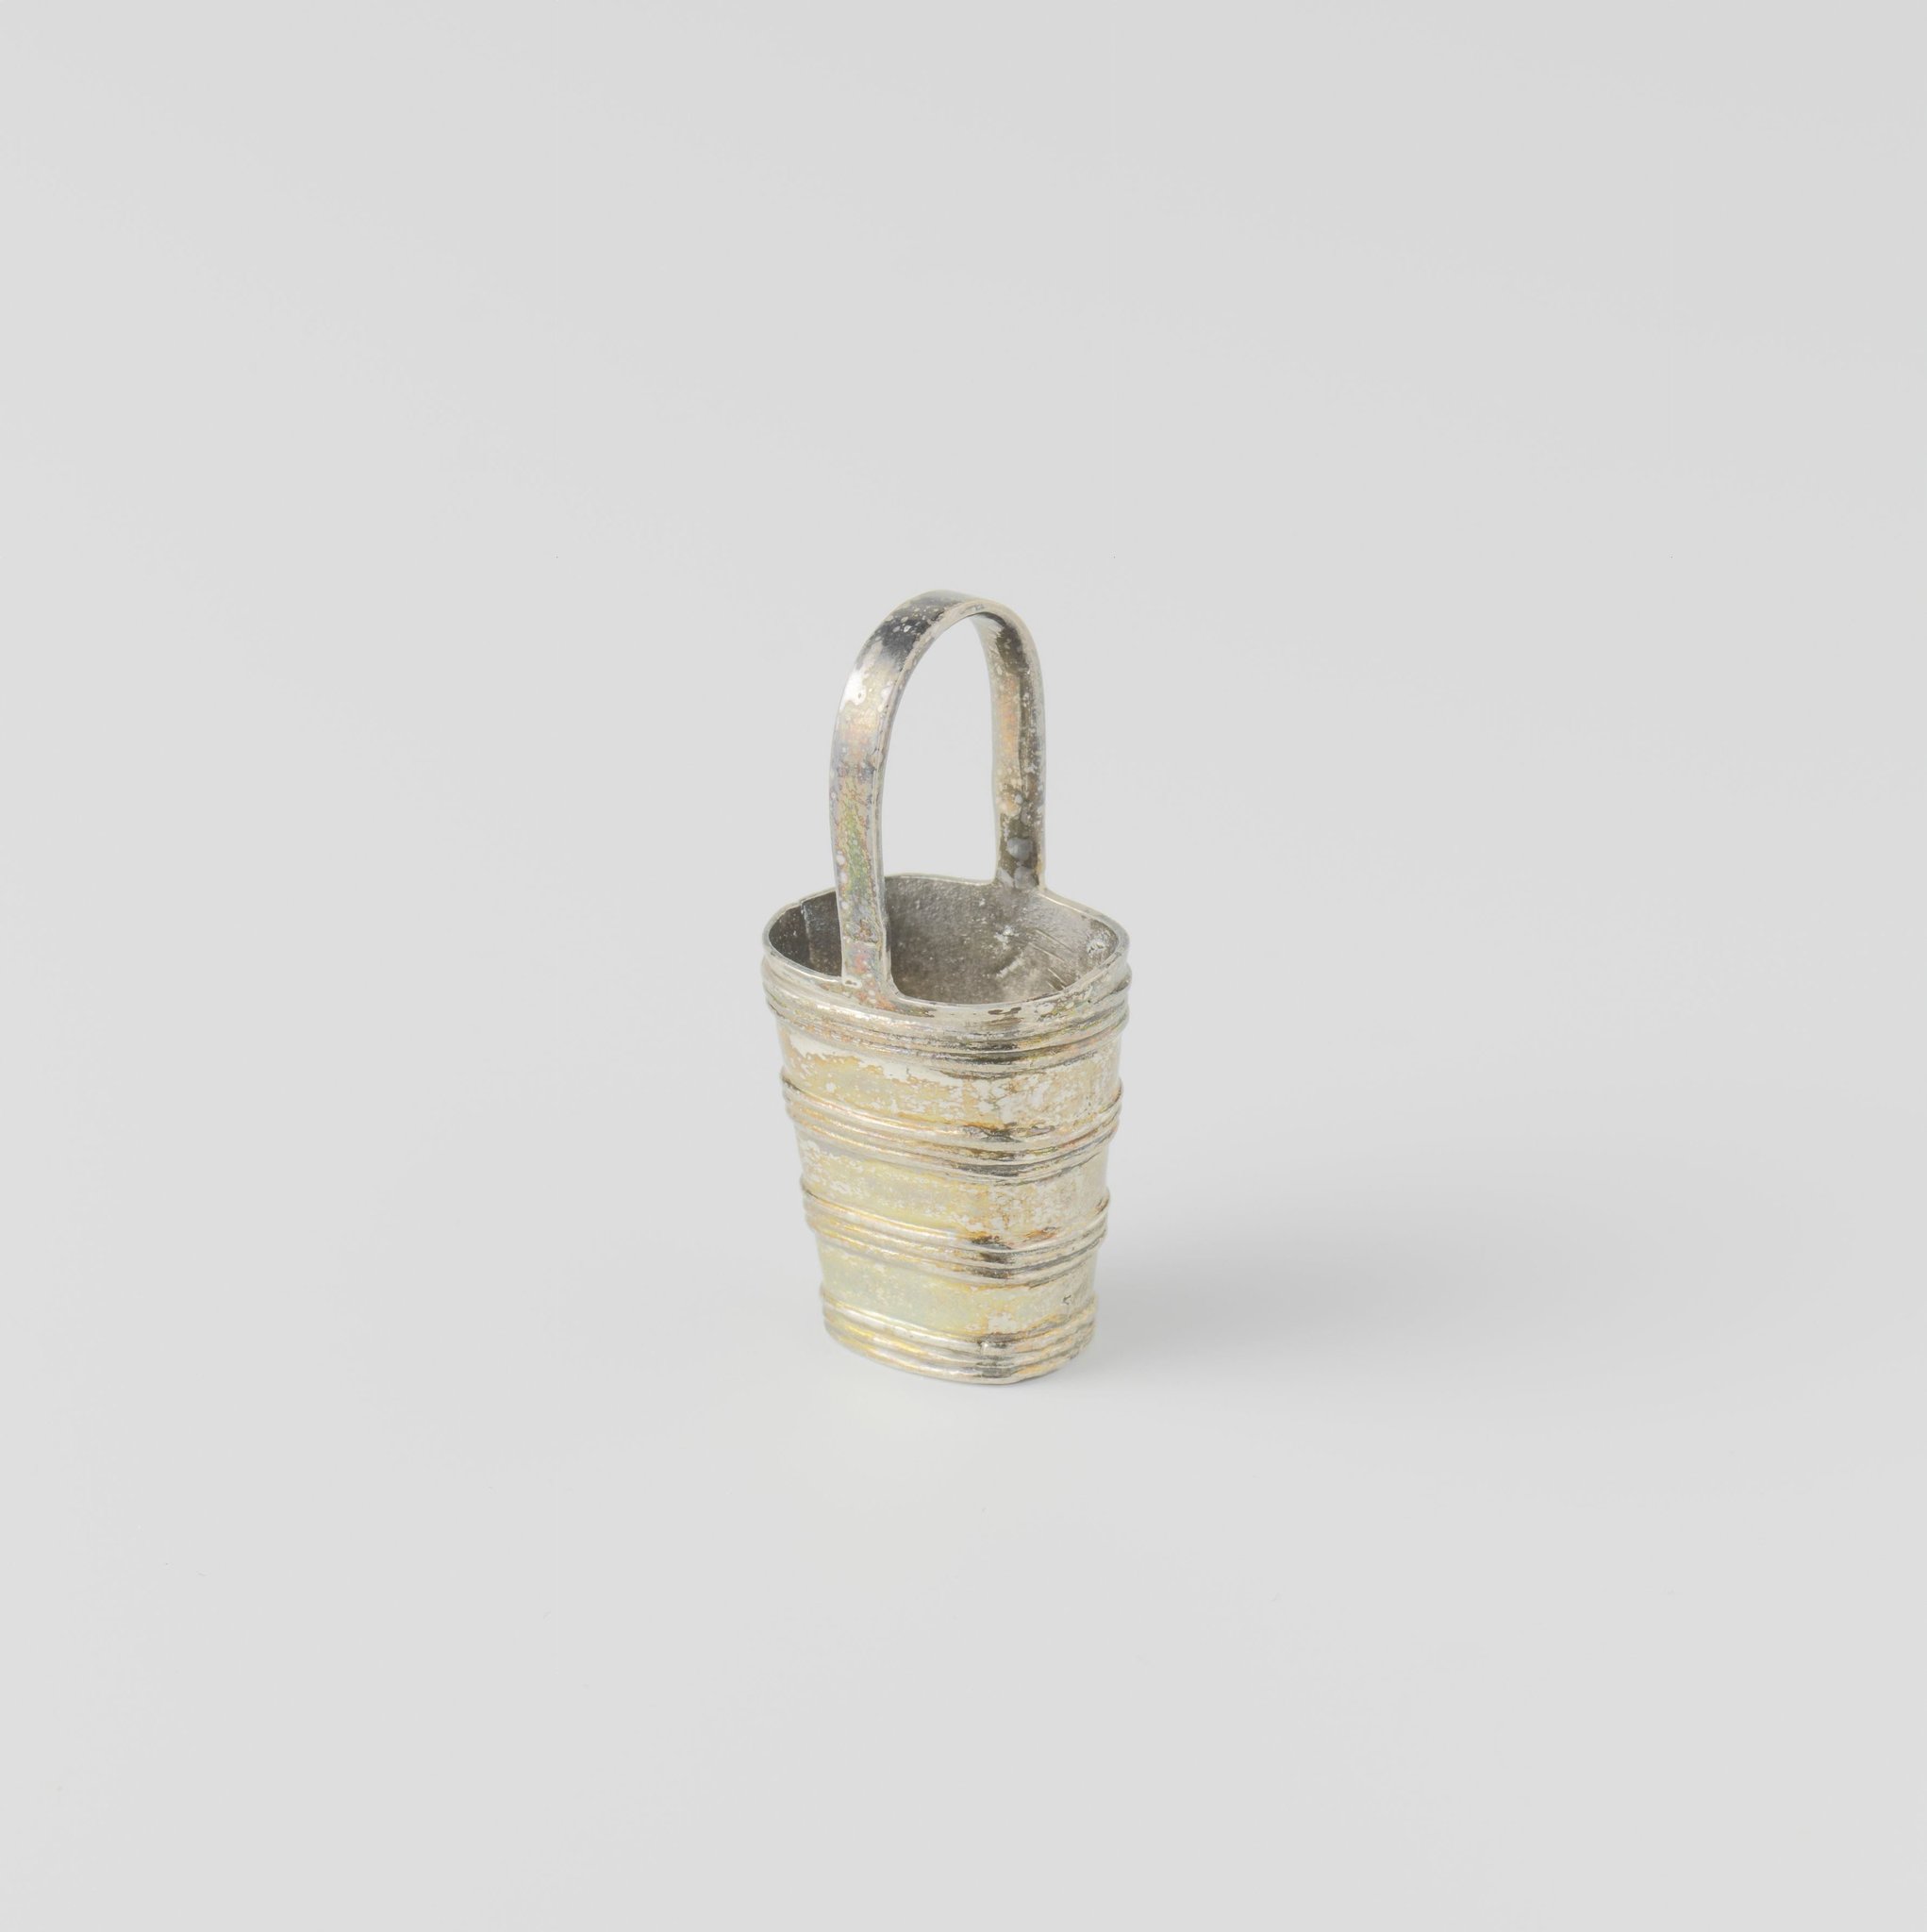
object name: miniature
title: Moppentrommel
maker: hendrik van der star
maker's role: silversmith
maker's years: 1619-1689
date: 1660-1690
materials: silver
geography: amsterdam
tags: container of metal: bucket, can, canister, drum, tin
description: Hoge, afgeronde rechthoekige mand. De mand loopt naar boven breed uit en heeft een vast hengsel. De wand van de mand is versierd met horizontale banden. De mand is gemerkt met een zespuntige ster in een cirkel en een dolfijn.